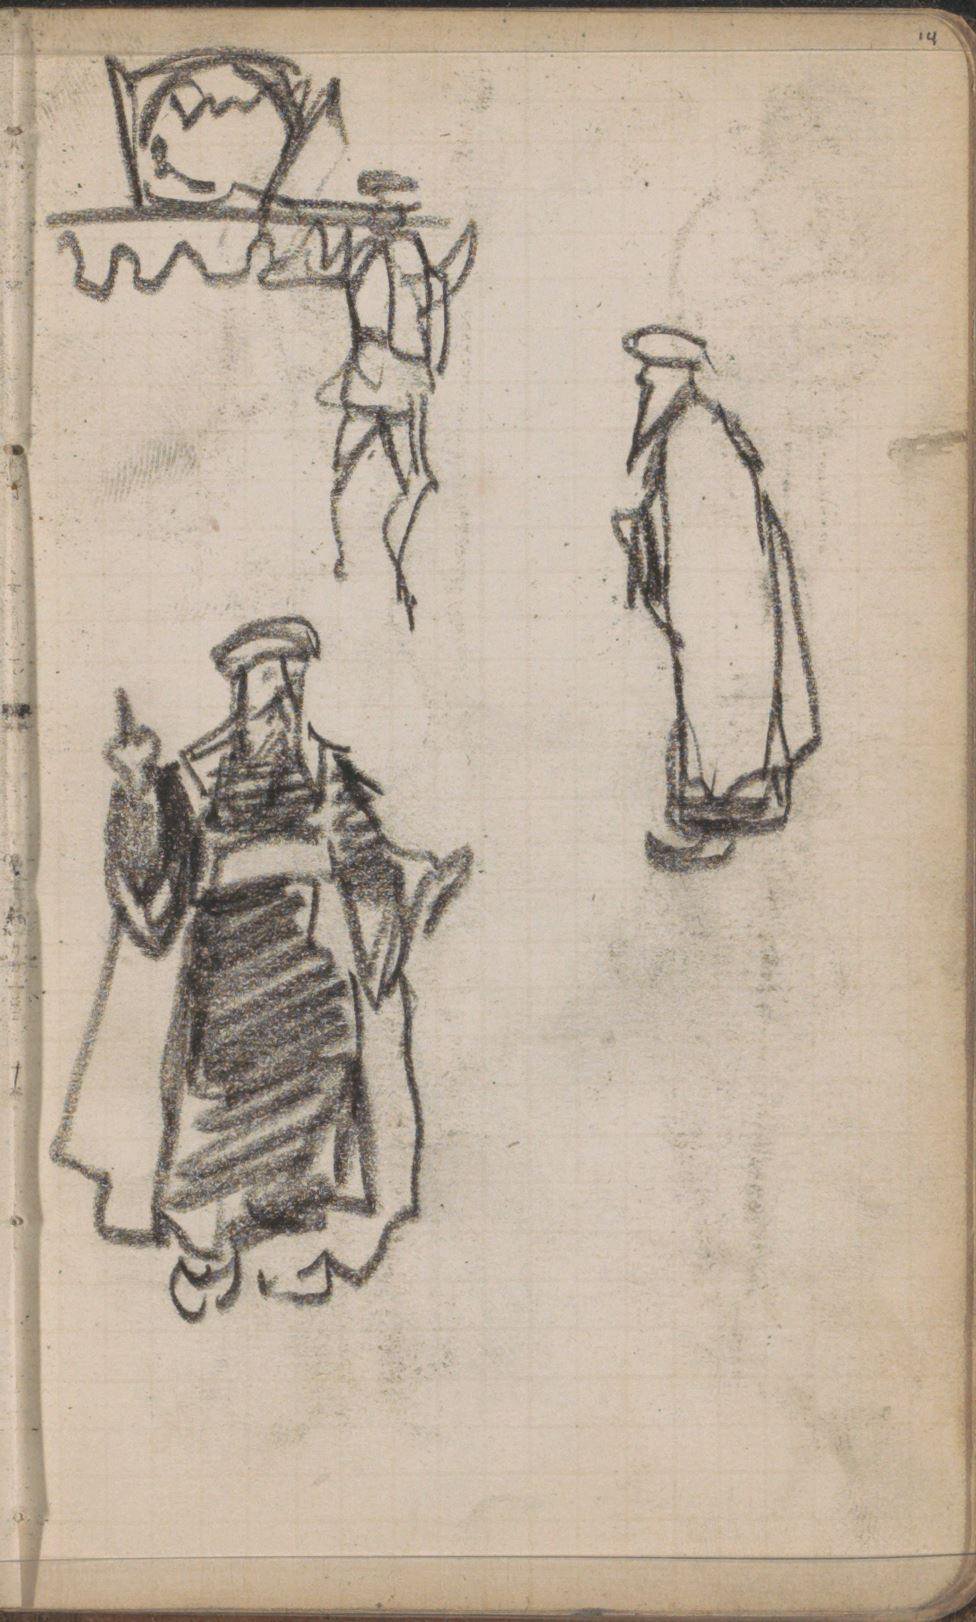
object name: sketchbook leaf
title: Figuren in historisch kostuum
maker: marius bauer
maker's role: draughtsman, print maker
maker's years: 1867-1932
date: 1879-1885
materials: chalk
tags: riding a horse, ass, or mule; rider, horseman, standing figure, adult man, historical costume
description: Mogelijk kostuums voor een theaterstuk. Pagina 14 uit een schetsboek met 58 bladen.